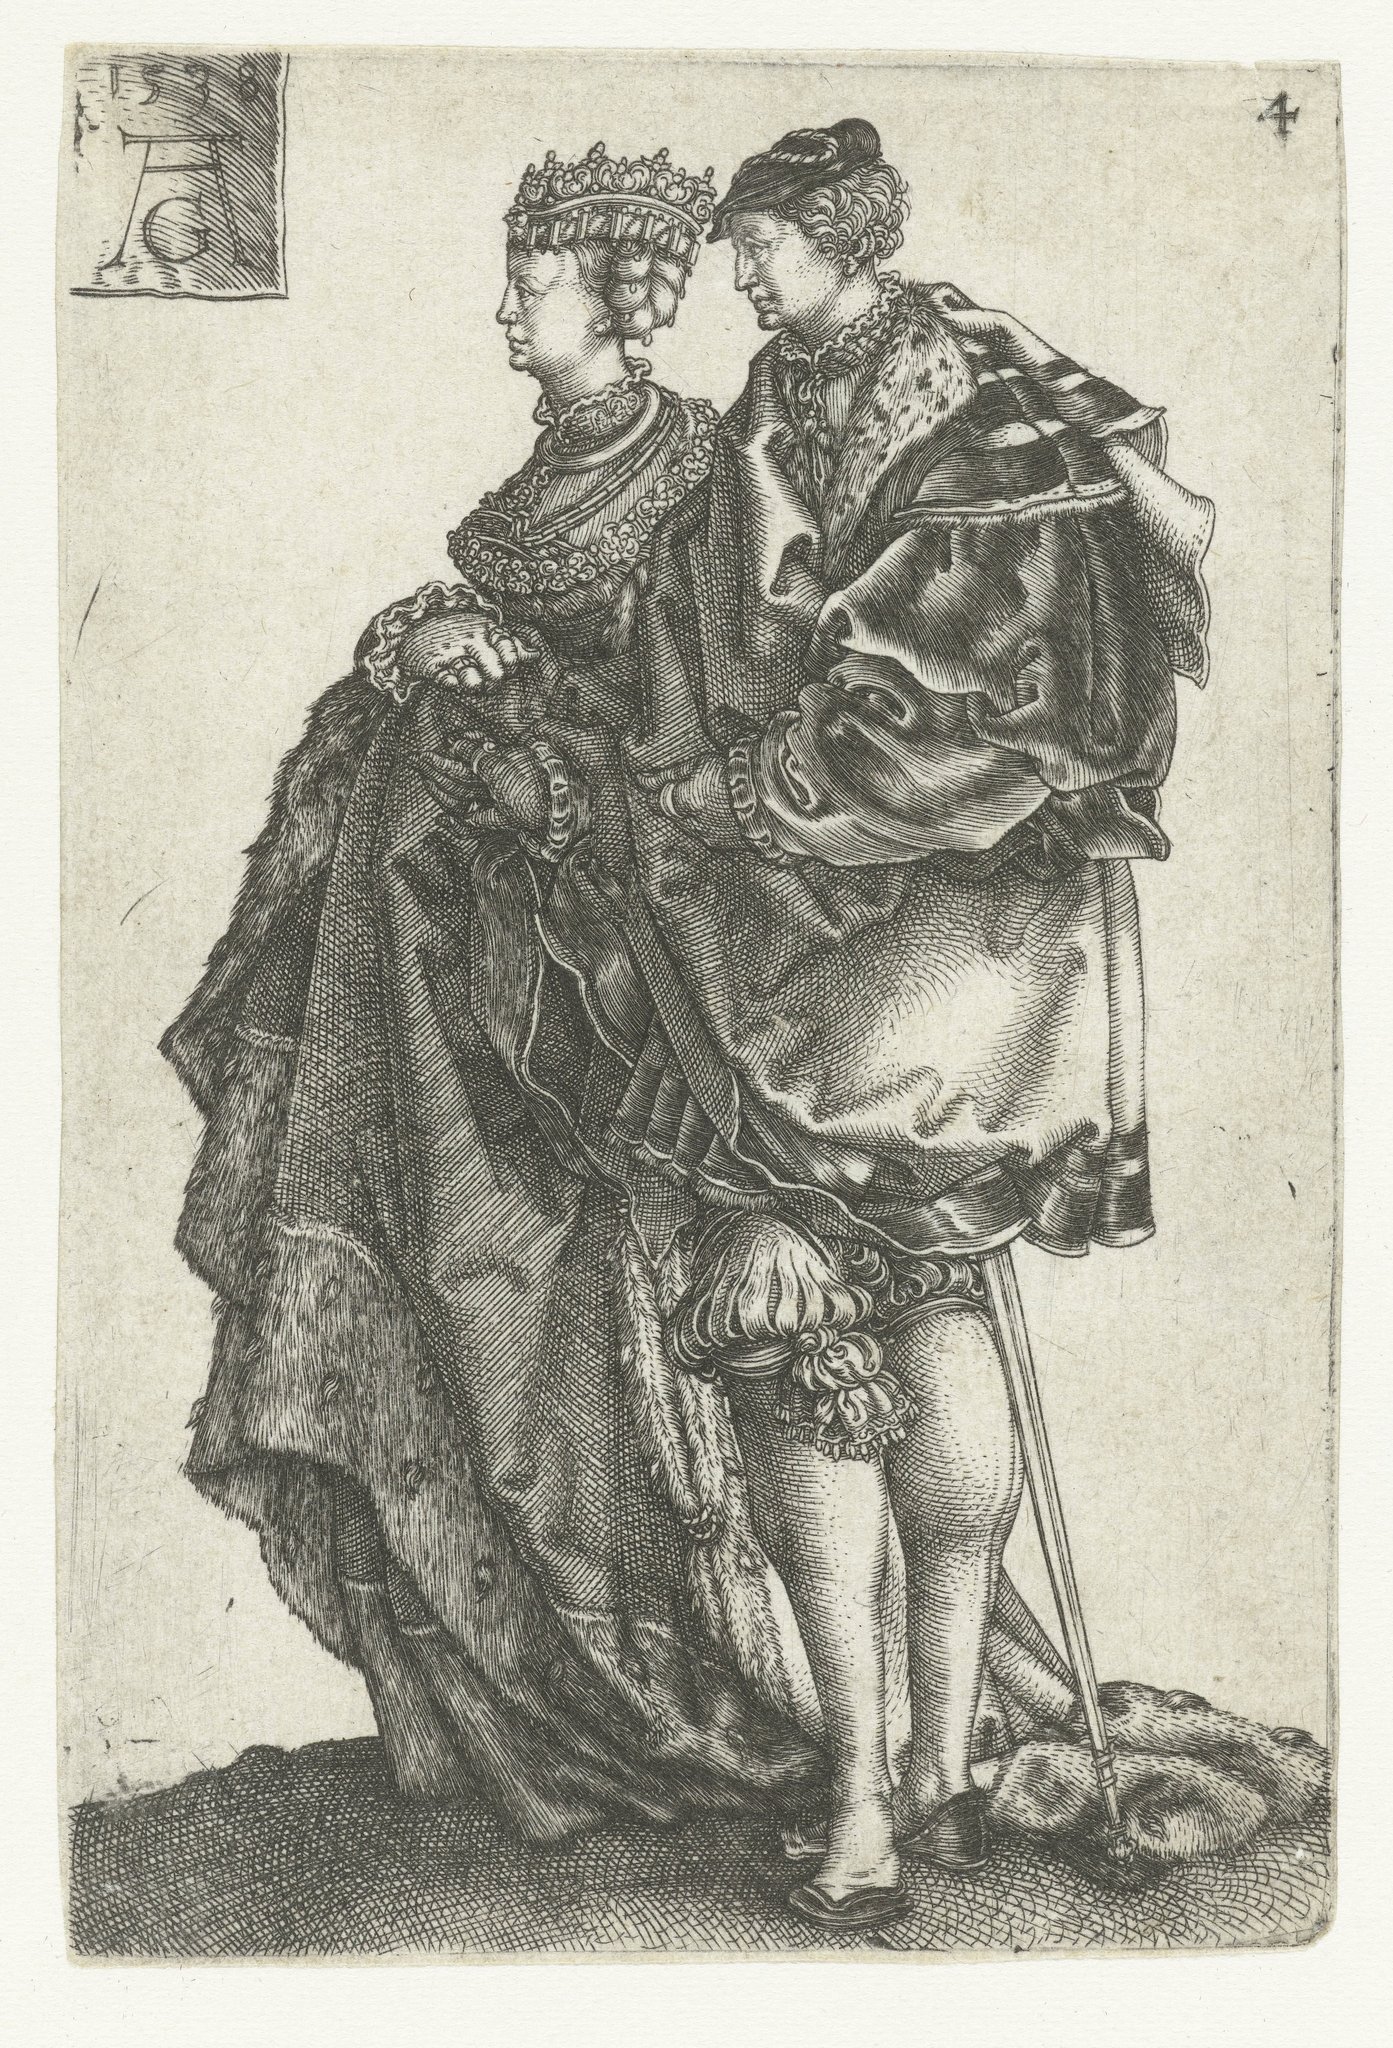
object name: print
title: Dansend paar no. 4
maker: heinrich aldegrever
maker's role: draughtsman, print maker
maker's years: 1502-1561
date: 1538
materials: paper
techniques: engraving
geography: germany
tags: dancing at wedding feast, one pair dancing; man and woman dancing as a couple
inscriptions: number: ‘95’, collector's mark: Lugt 2228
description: Datering Duitse kleding: 1530-1540. Man: korte tabbaard, kniebroek met passement en strik op de knie. Koemuilen.